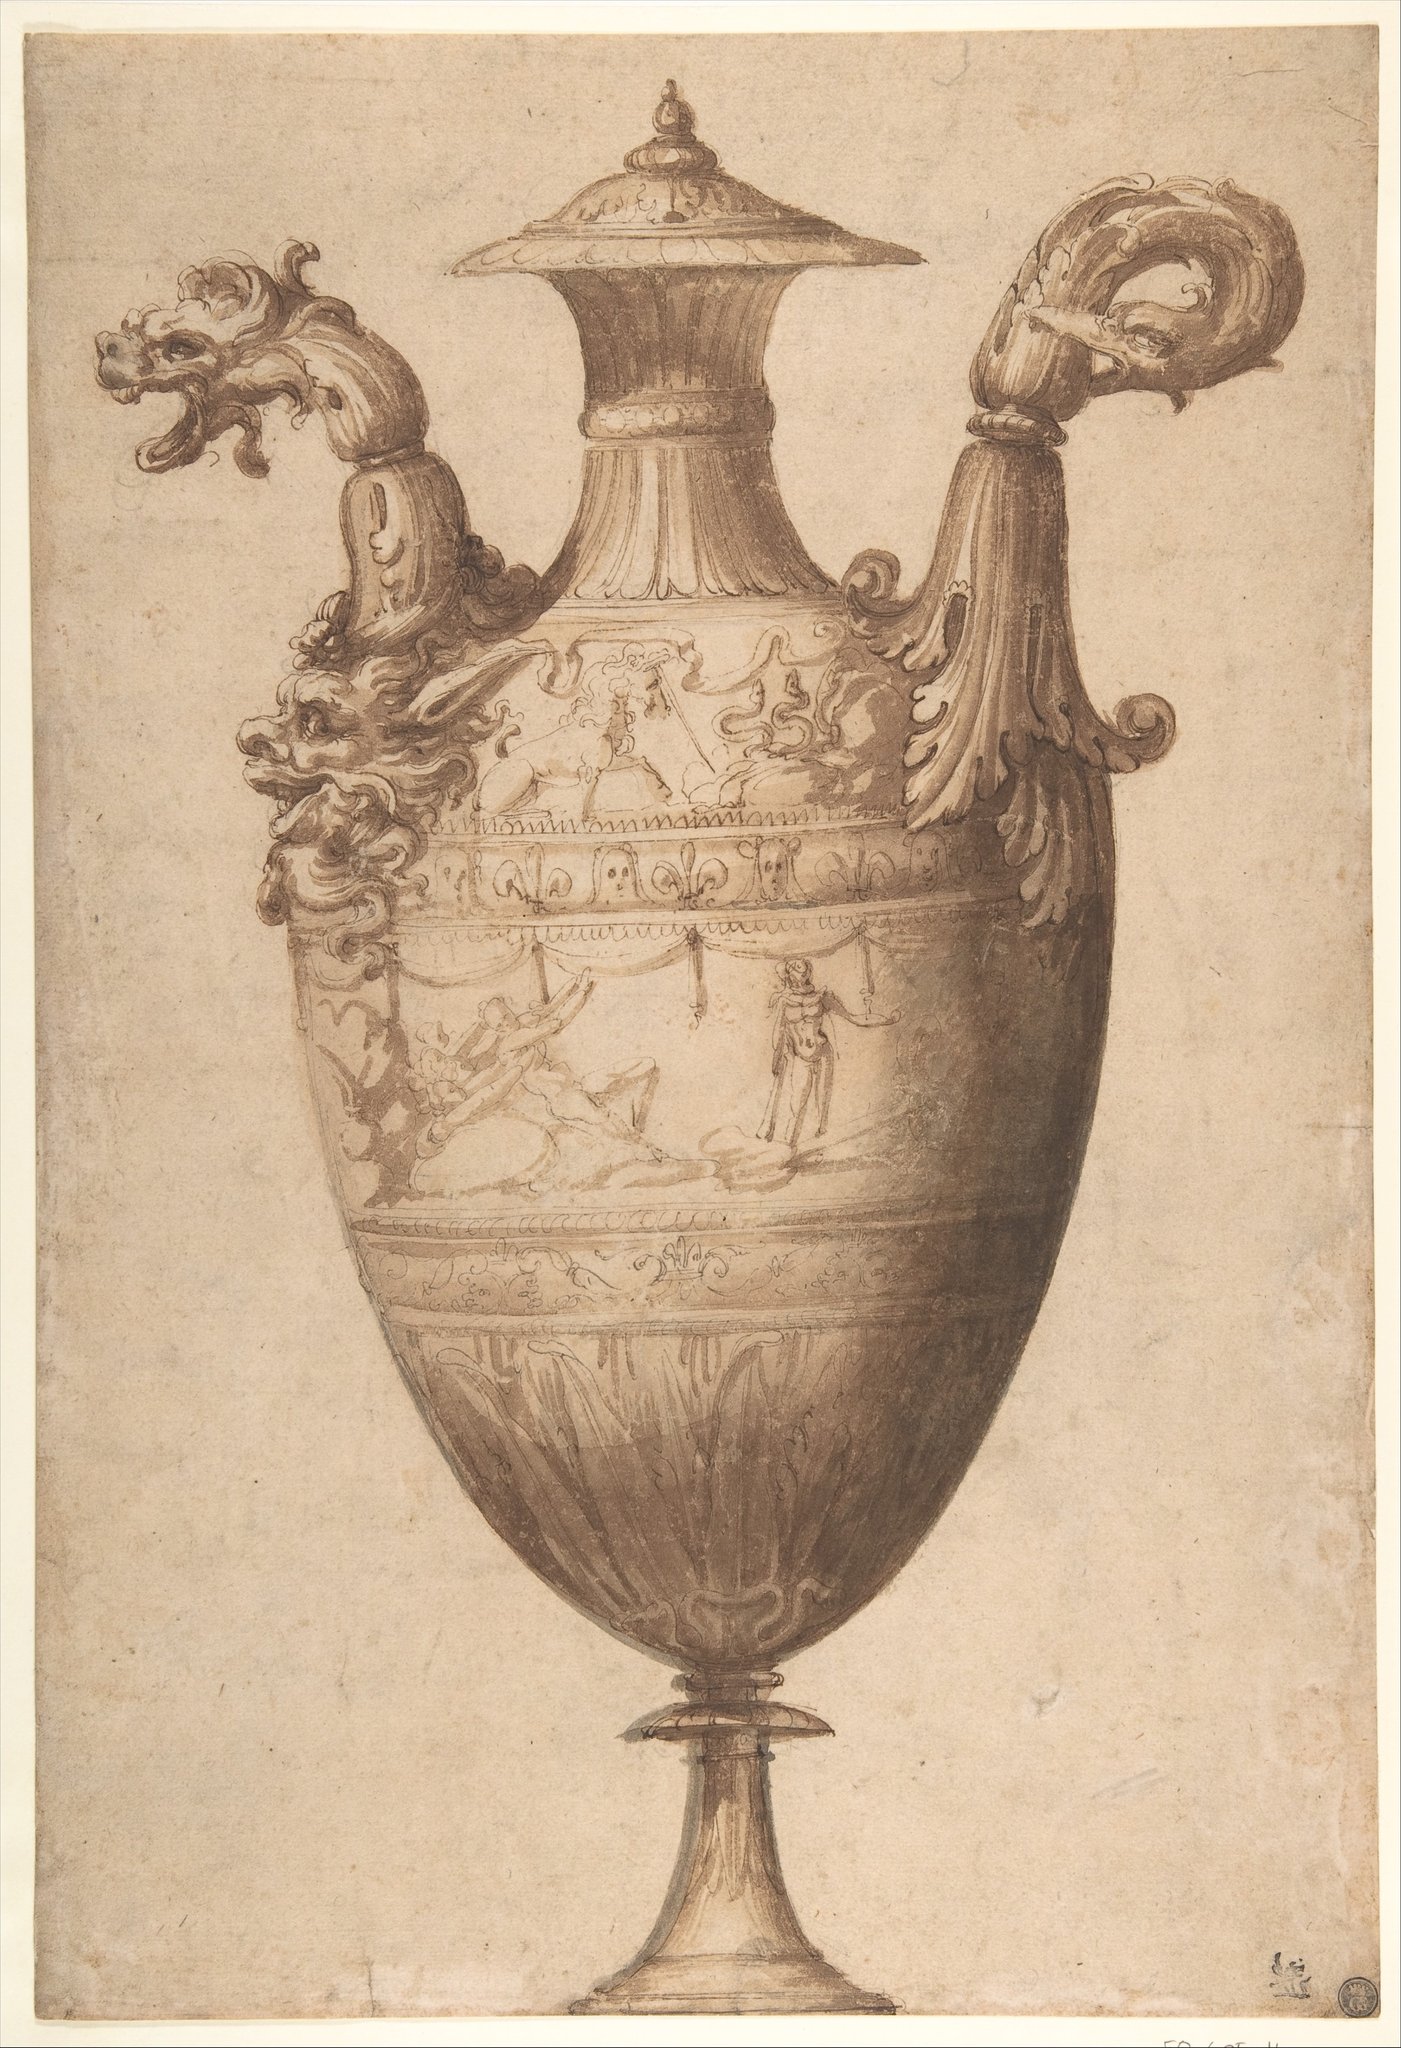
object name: drawing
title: Design for a Vase with Hercules and Farnese Lilies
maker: francesco salviati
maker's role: artist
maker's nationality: italian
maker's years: 1510-1563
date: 1540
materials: ink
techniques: brush, pen, wash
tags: hercules,lilies,vases